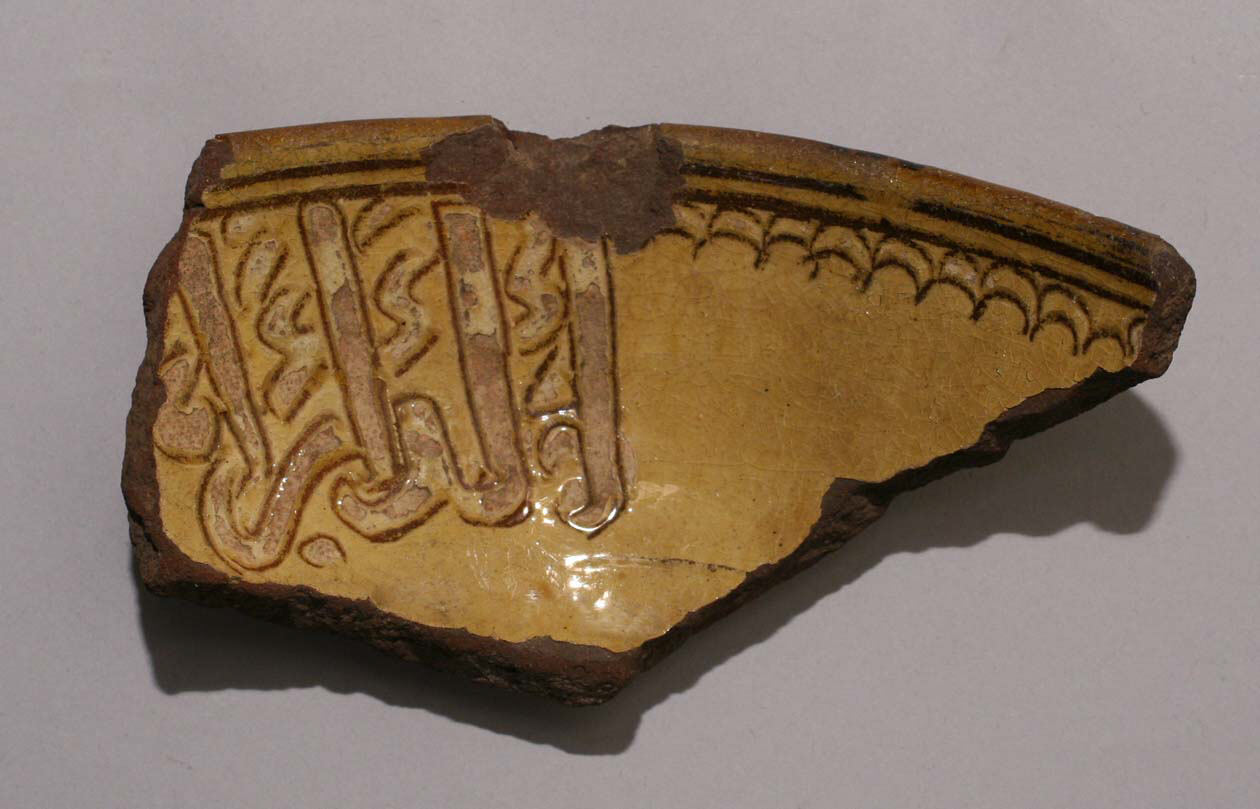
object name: fragment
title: Ceramic Fragment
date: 1301-1500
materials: earthenware, glaze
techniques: coloring, incising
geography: egypt